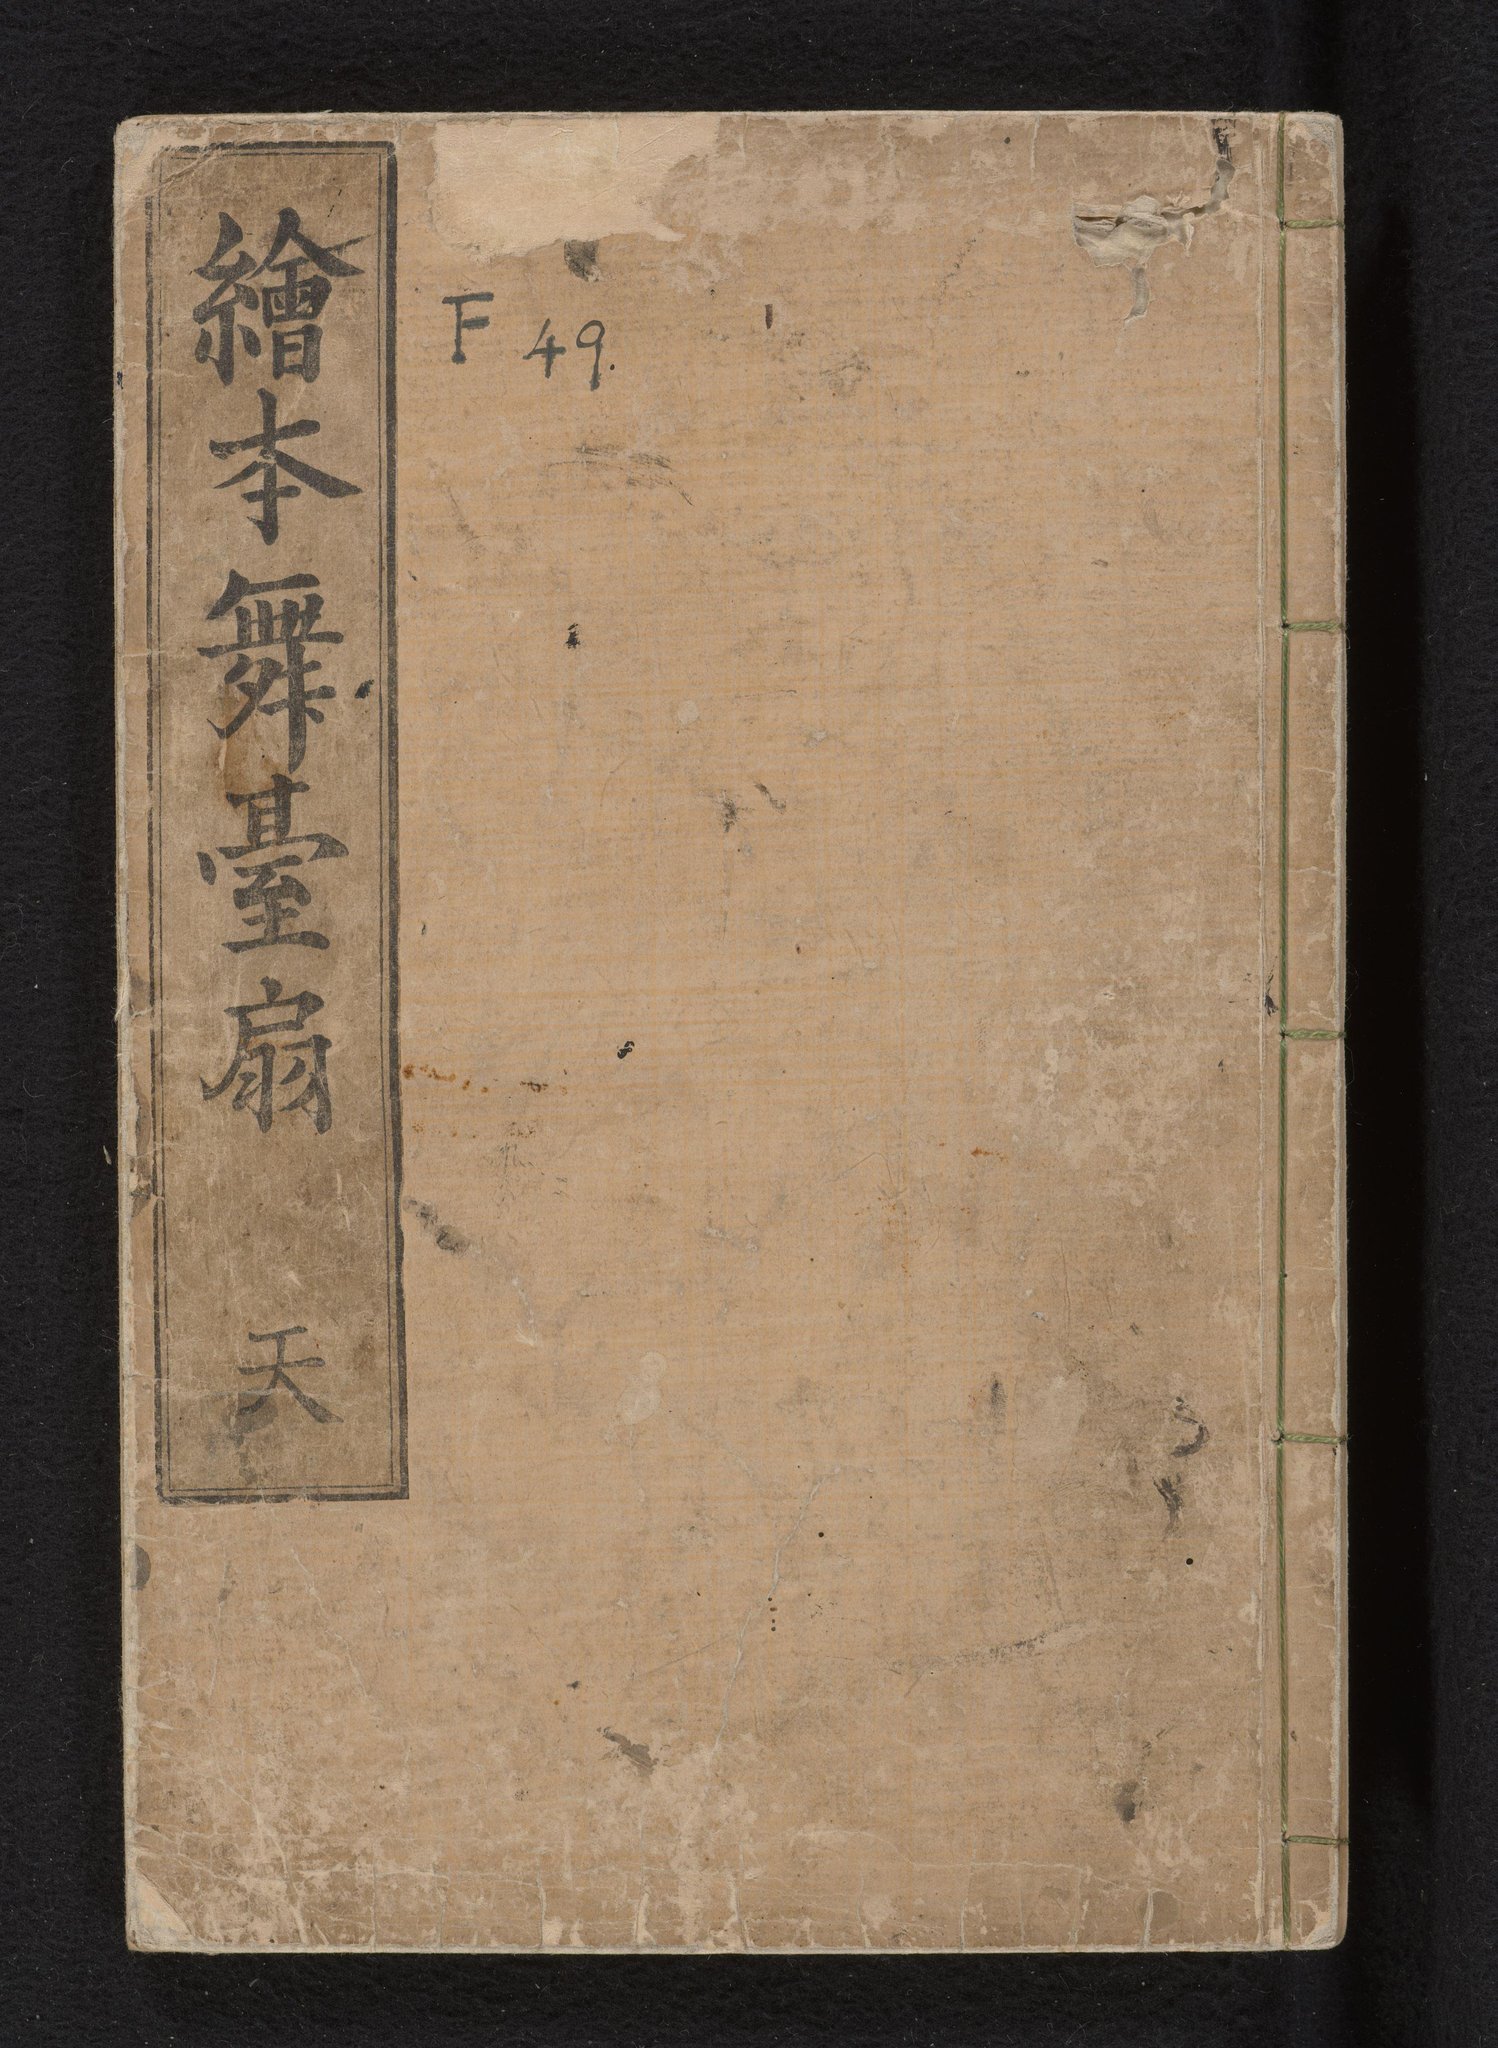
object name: book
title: Ehon butai ogi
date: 1770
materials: paper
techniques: woodcut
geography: edo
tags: portrait of actor, actress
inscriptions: date